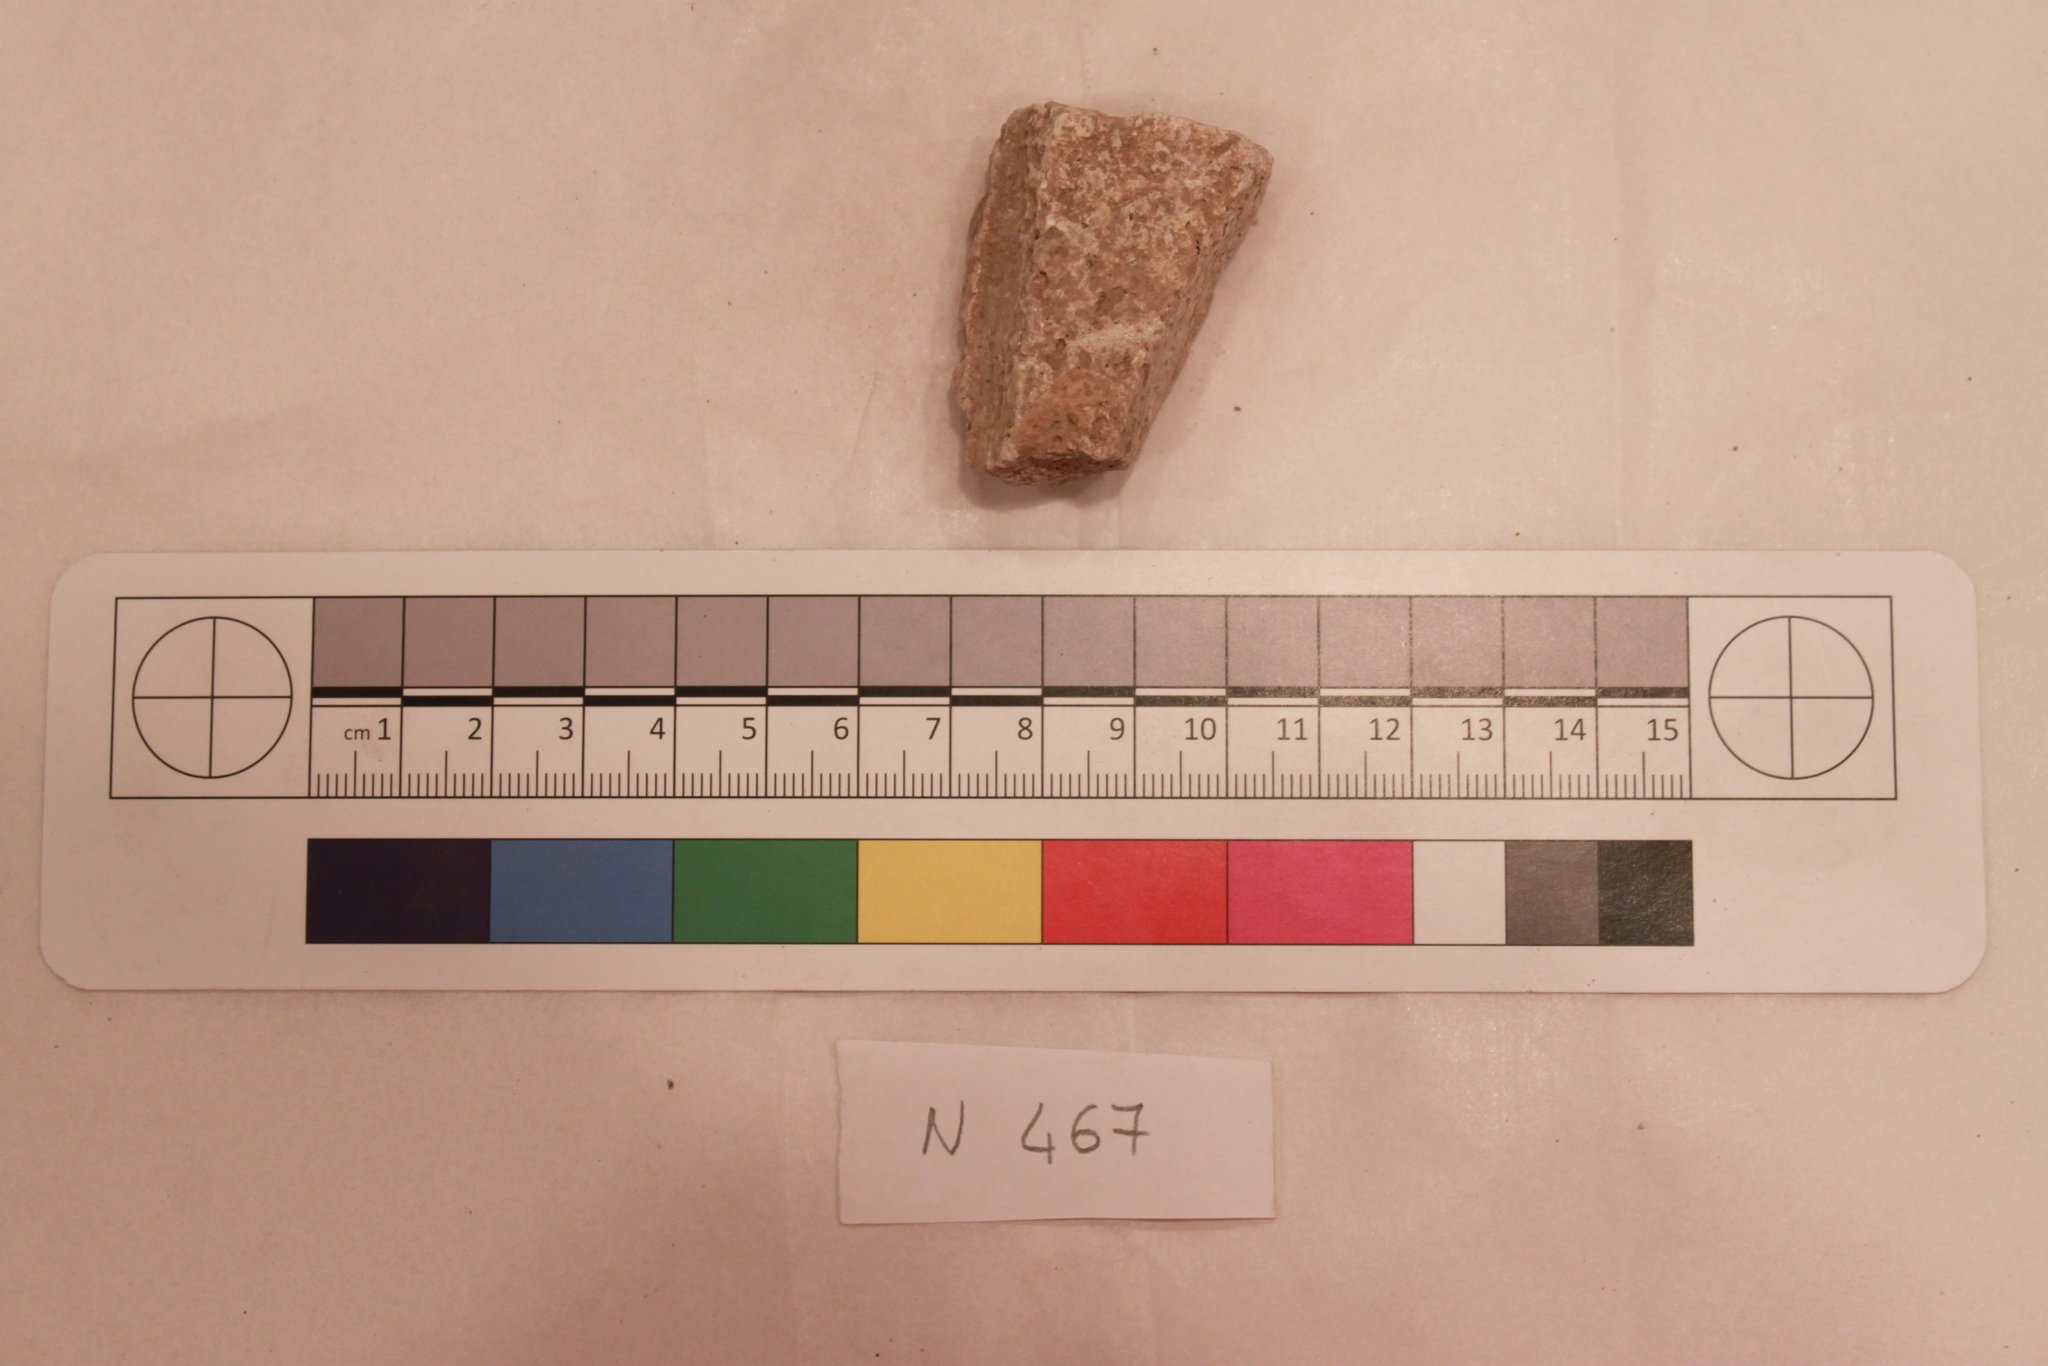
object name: fragment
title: Stucco Fragment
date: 701-1200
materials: plaster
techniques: carving, painting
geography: iran